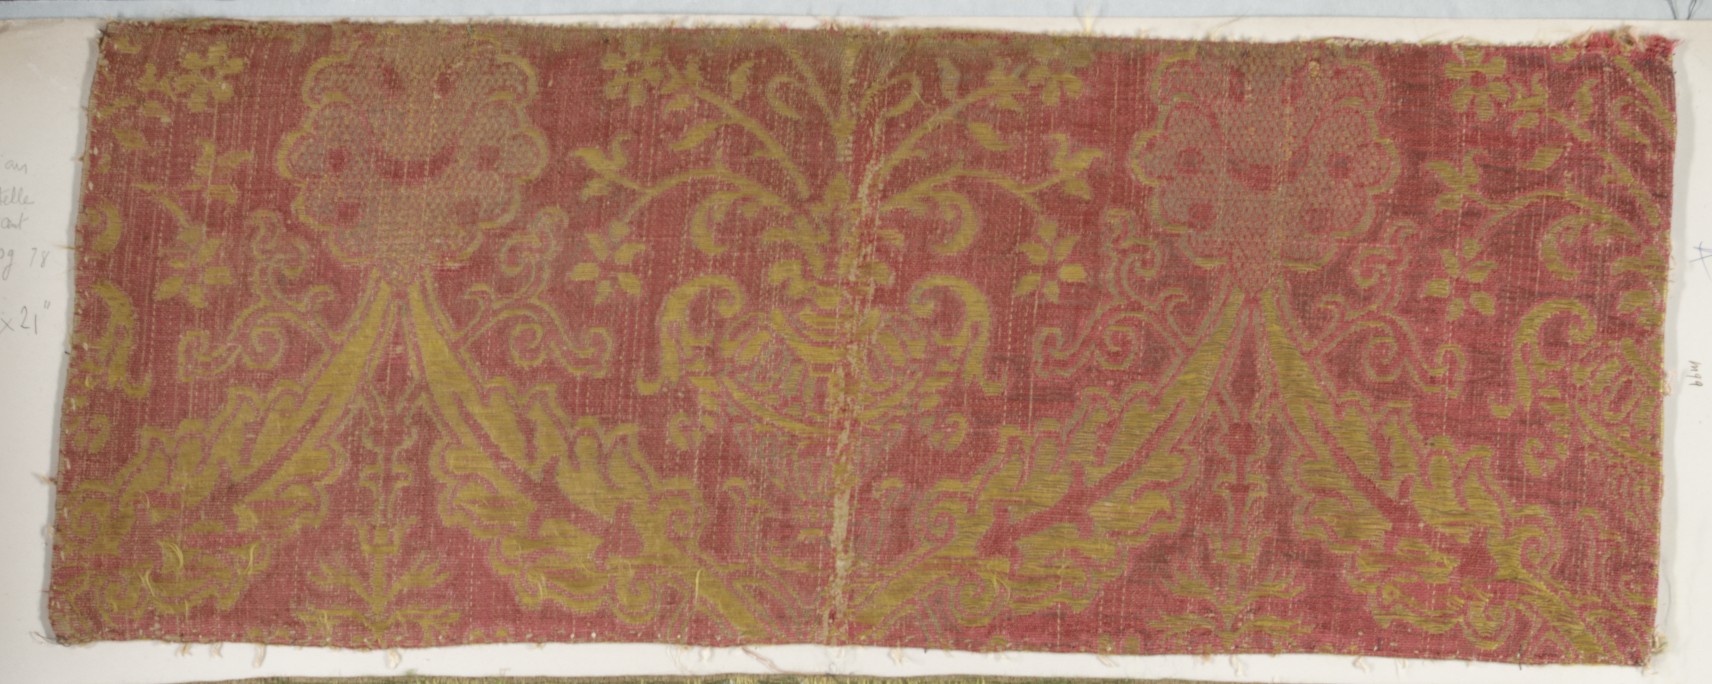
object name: fragment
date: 1601-1700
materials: metal thread, silk